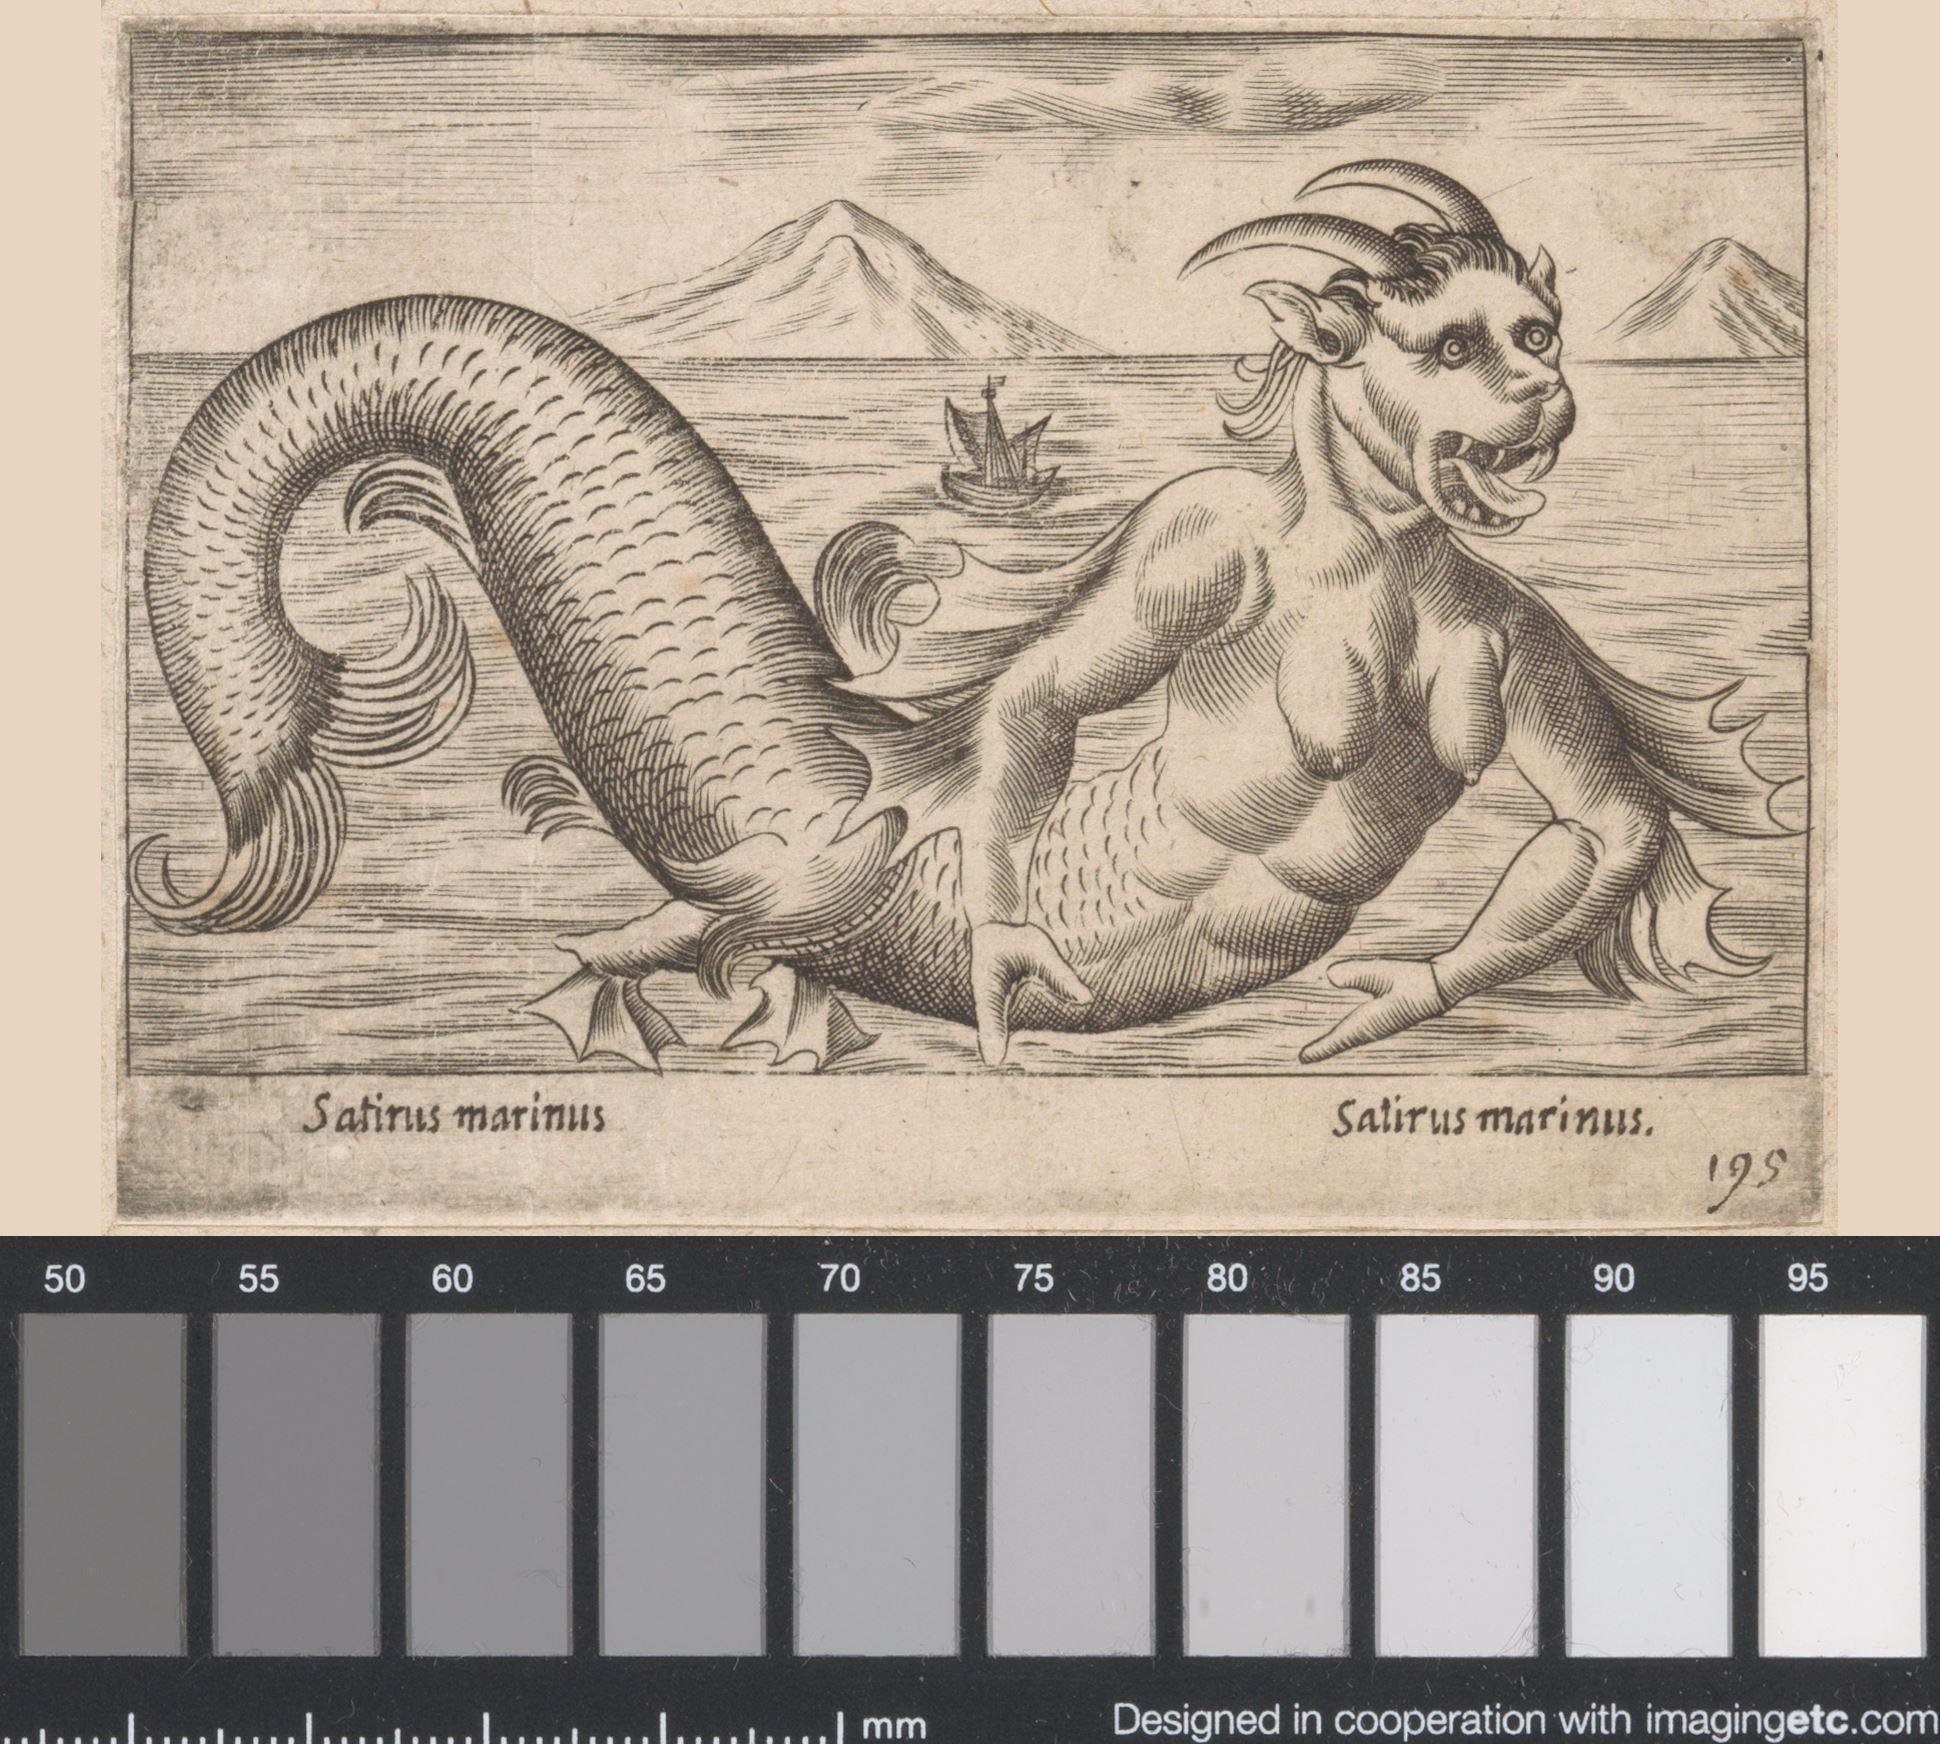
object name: print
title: Nova raccolta de li animali piu curiosi del mondo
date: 1565-1630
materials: paper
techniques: etching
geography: vatican city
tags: monsters of the sea, mis-shapen animals; monsters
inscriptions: collector's mark: Lugt 11, number: ‘195’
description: Deze prent maakt deel uit van een reeks prenten van dieren door Antonio Tempesta. Bekend is dat een tweede staat (met nummering) van deze serie is uitgegeven door Giovanni Giacomo de' Rossi in 1650. Onbekend is wie de eerste staat heeft uitgegeven en wanneer.